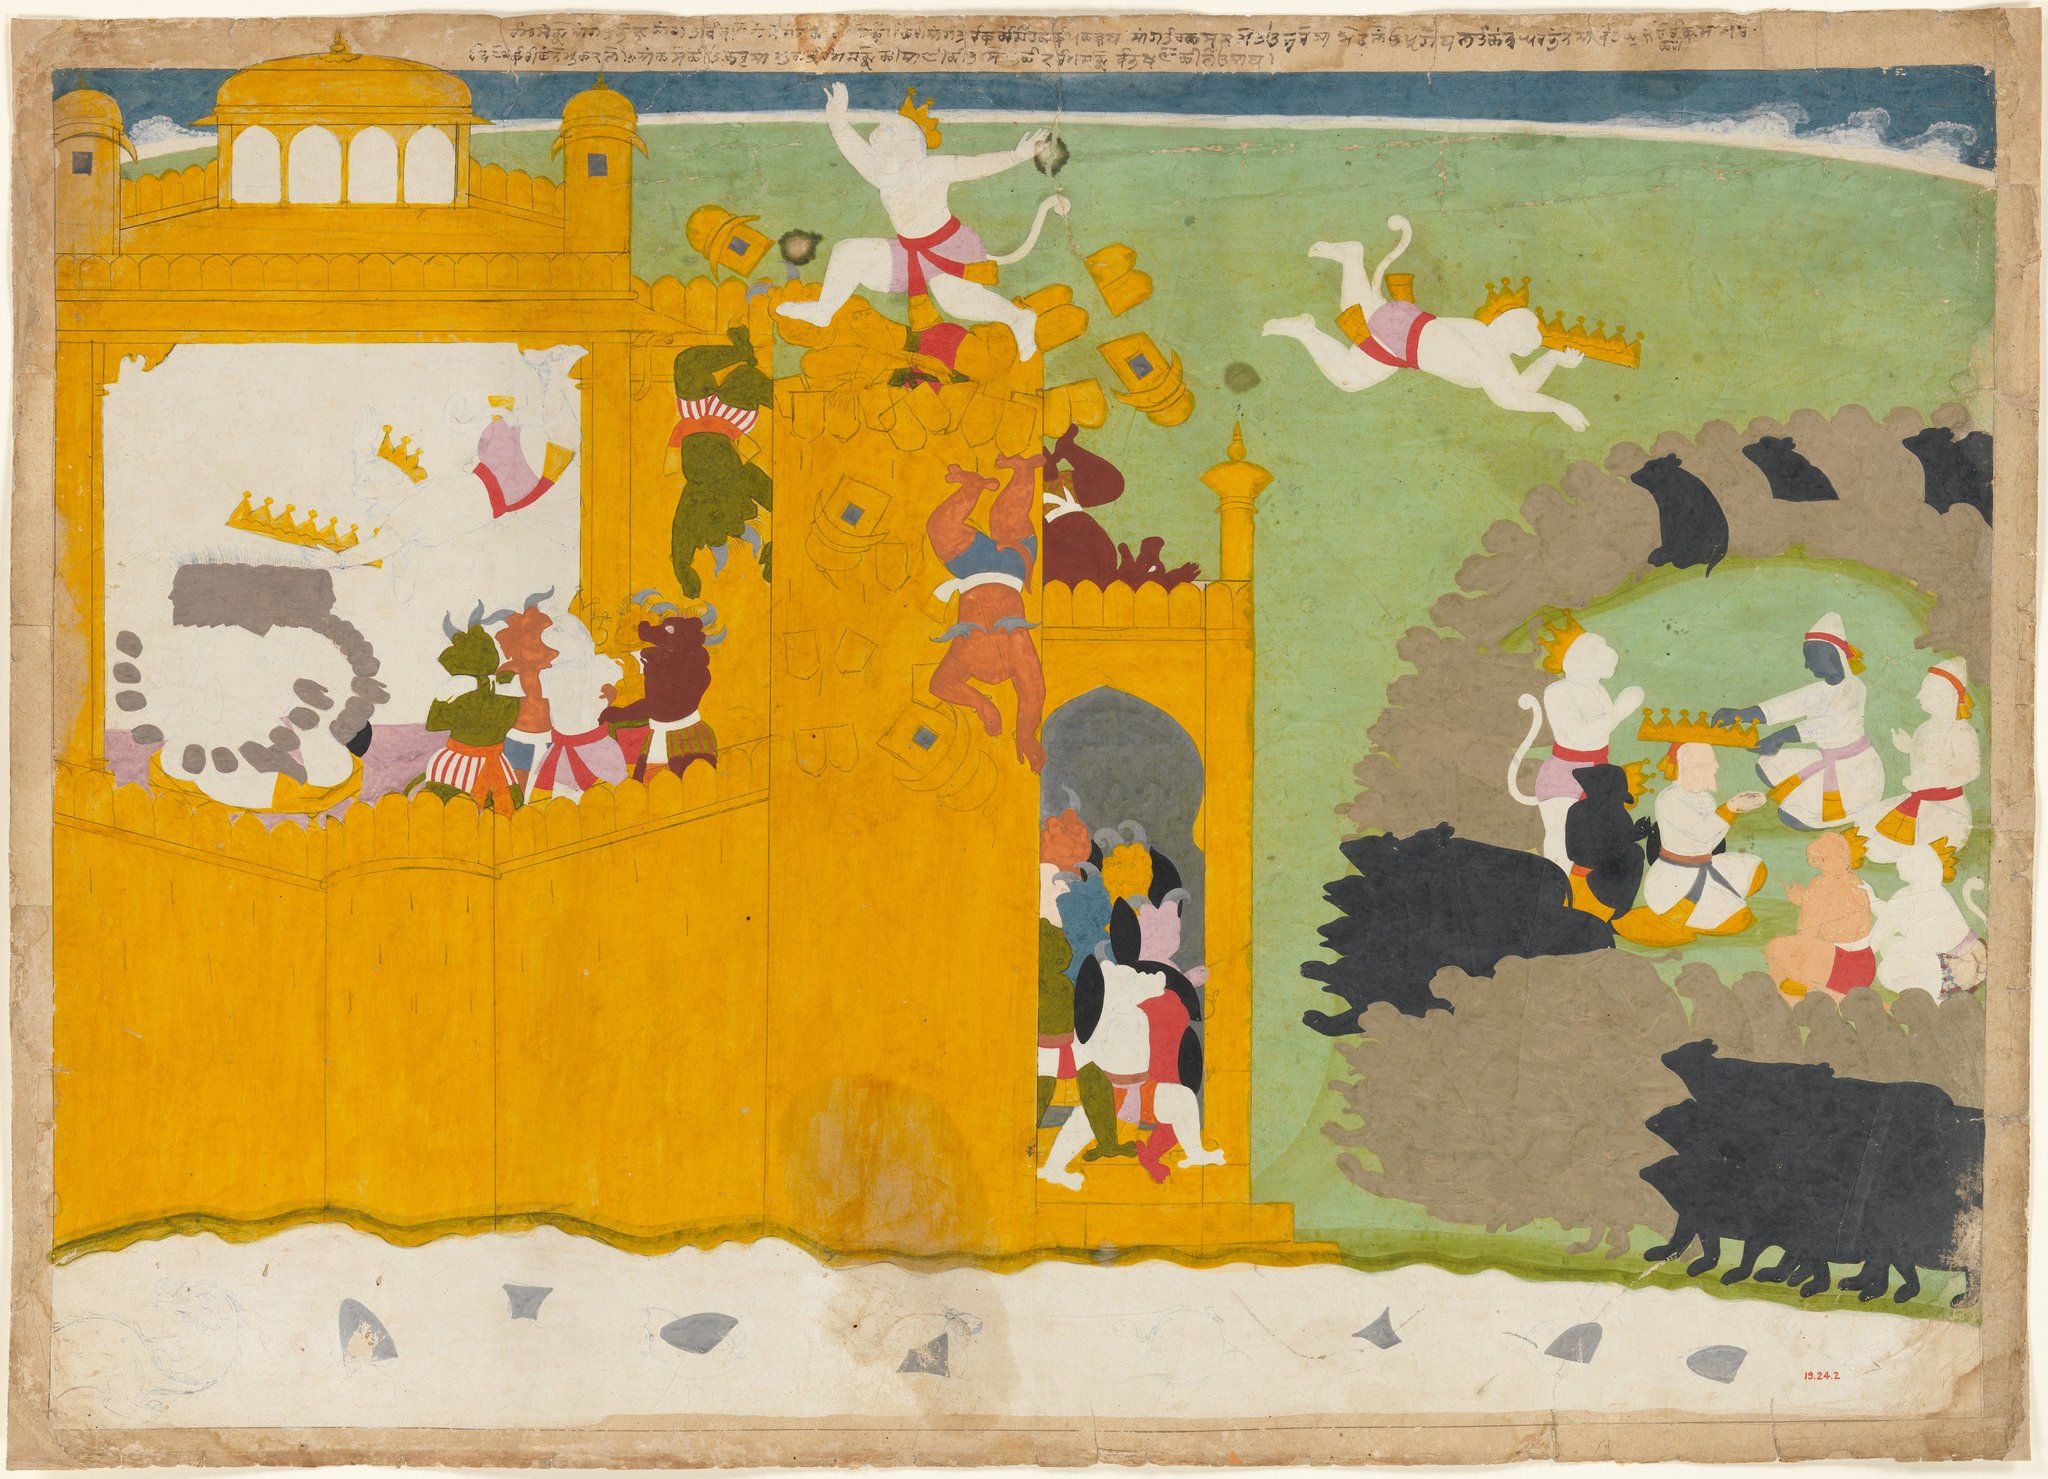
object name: folio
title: The Monkey Leader Angada Steals Ravana's Crown from His Fortress: Folio from the Siege of Lanka series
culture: indian, punjab hills, guler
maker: manaku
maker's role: artist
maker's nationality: indian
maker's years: 1715-1770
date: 1725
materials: ink, paper, watercolor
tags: monkeys